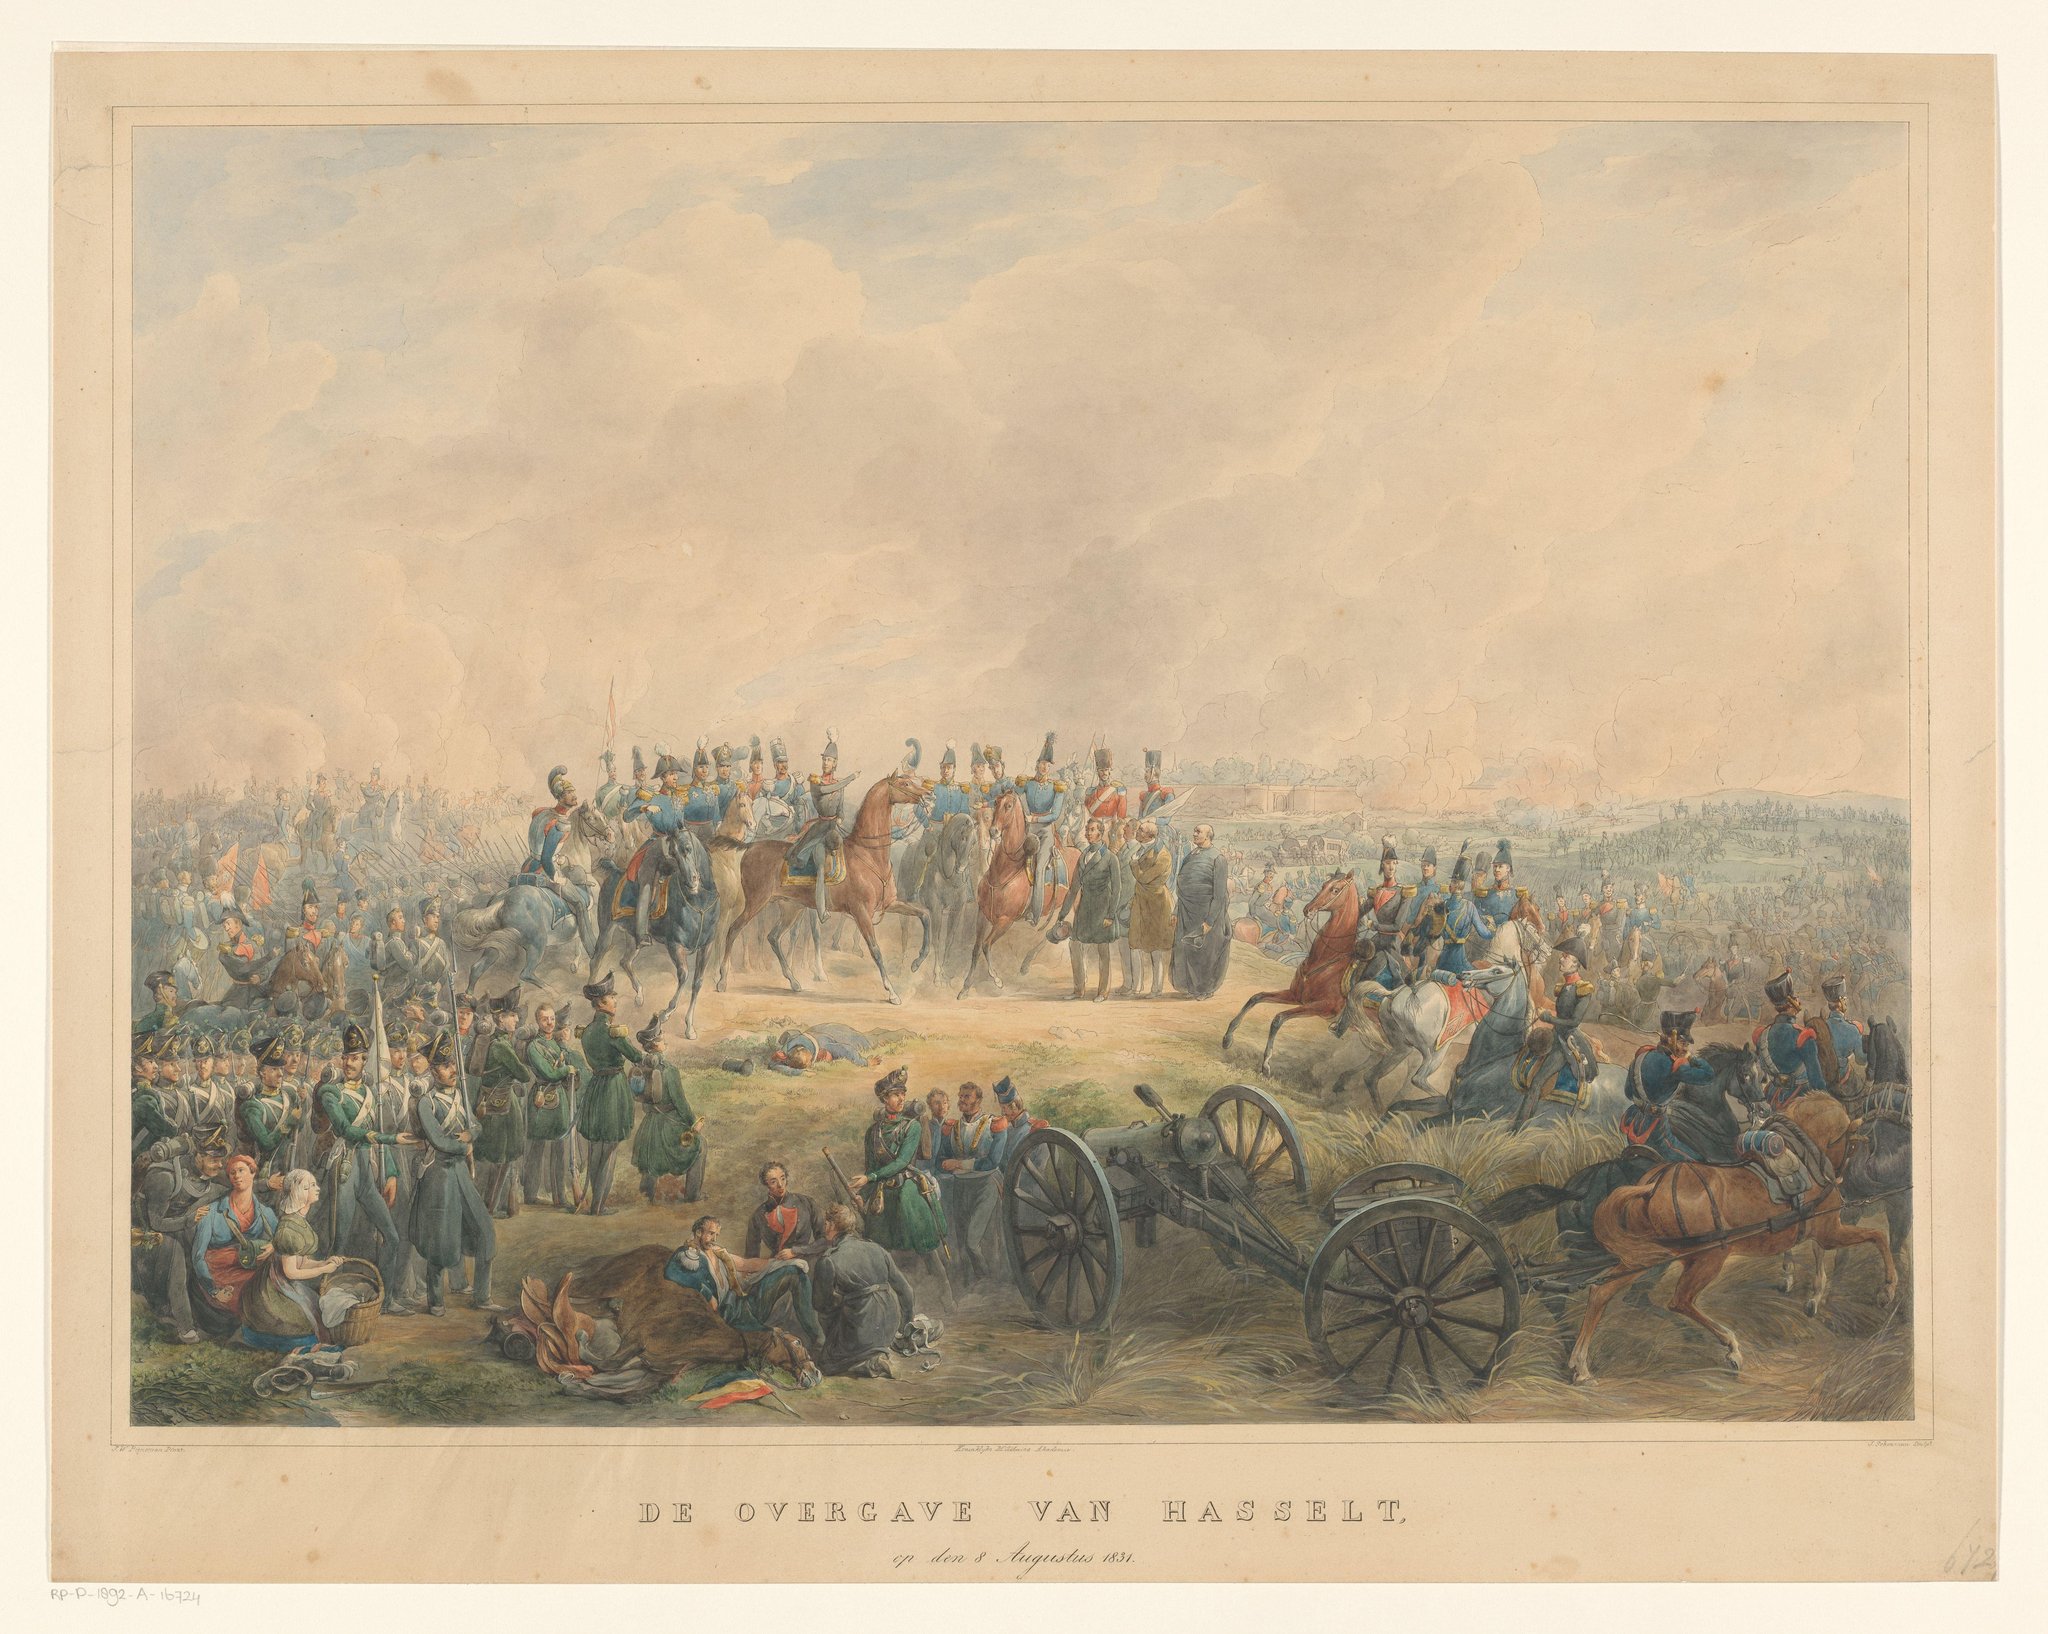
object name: print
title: Overgave van Hasselt op 8 augustus 1831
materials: paper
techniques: hand coloring, lithograph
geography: breda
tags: the hague, william ii of the netherlands, berlin, frederik (prins der nederlanden), battle (+ land forces), surrender ~ war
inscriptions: collector's mark: Lugt 2228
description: De overgave van de stad Hasselt aan de Nederlandse troepen onder bevel van de prins van Oranje, 8 augustus 1831. Gezicht op het slagveld met centraal op een heuvel de prins omringd door zijn staf, allen te paard. Rechts van hen een afvaardiging van de stad Hasselt onder leiding van de burgemeester om over de overgave van de stad te onderhandelen. Rechts prins Frederik tussen enkele officieren. Op de voorgrond wordt een gewonde militair verzorgd. Aan de linkerkant leden van de Leidsche Vrijwillige Jagers en de Jagers van Rookmaker.